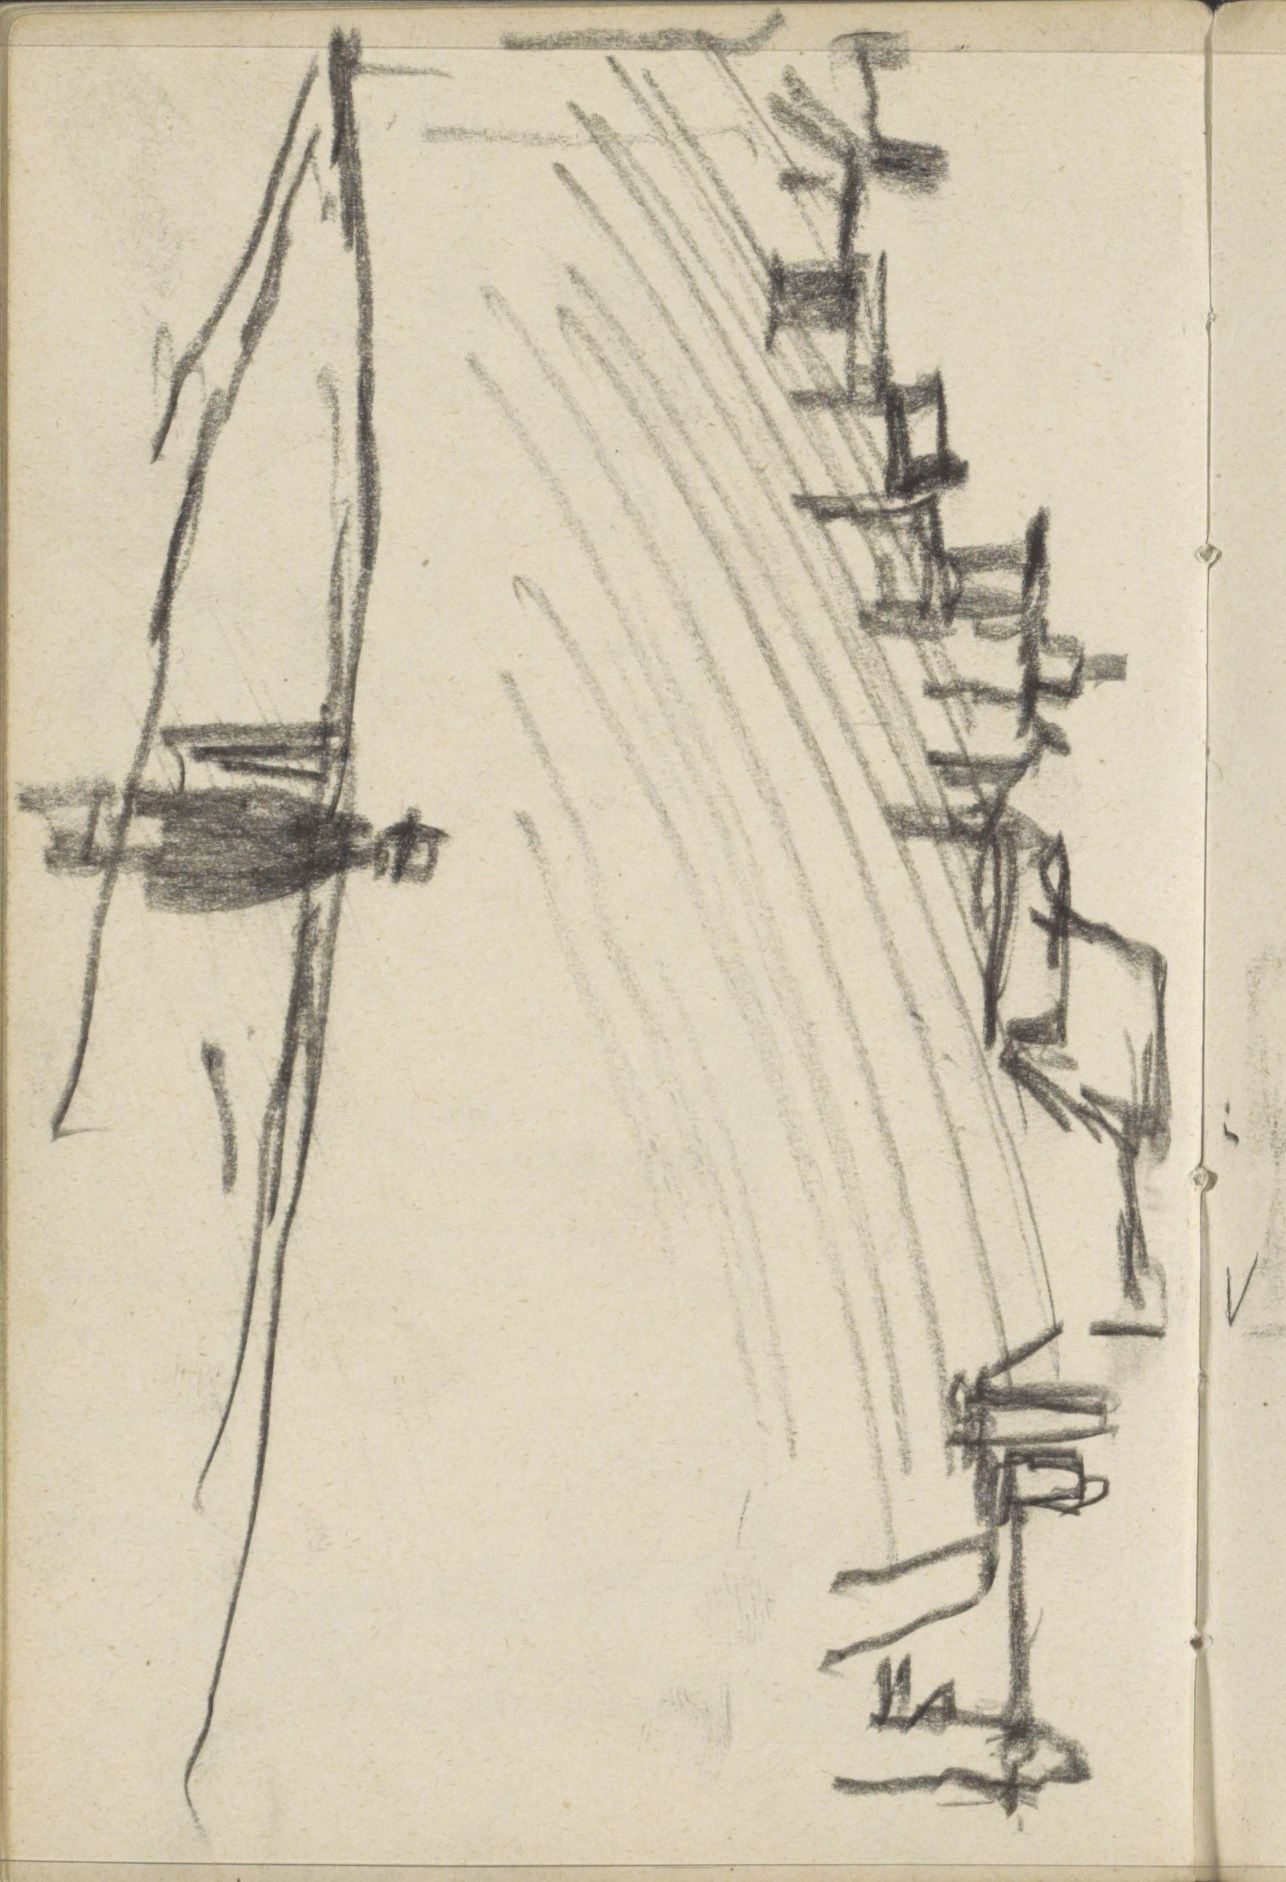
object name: sketchbook leaf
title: Gezicht in Amsterdam, mogelijk het Rokin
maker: george hendrik breitner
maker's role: draughtsman, painter, print maker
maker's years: 1857-1923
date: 1909-1912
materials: chalk, paper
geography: amsterdam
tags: urban housing, canals, waters (in city)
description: Gezicht in Amsterdam, mogelijk het Rokin. Vooraan een figuur. Pagina 81 uit een schetsboek met 46 bladen vervaardigd te Amsterdam.